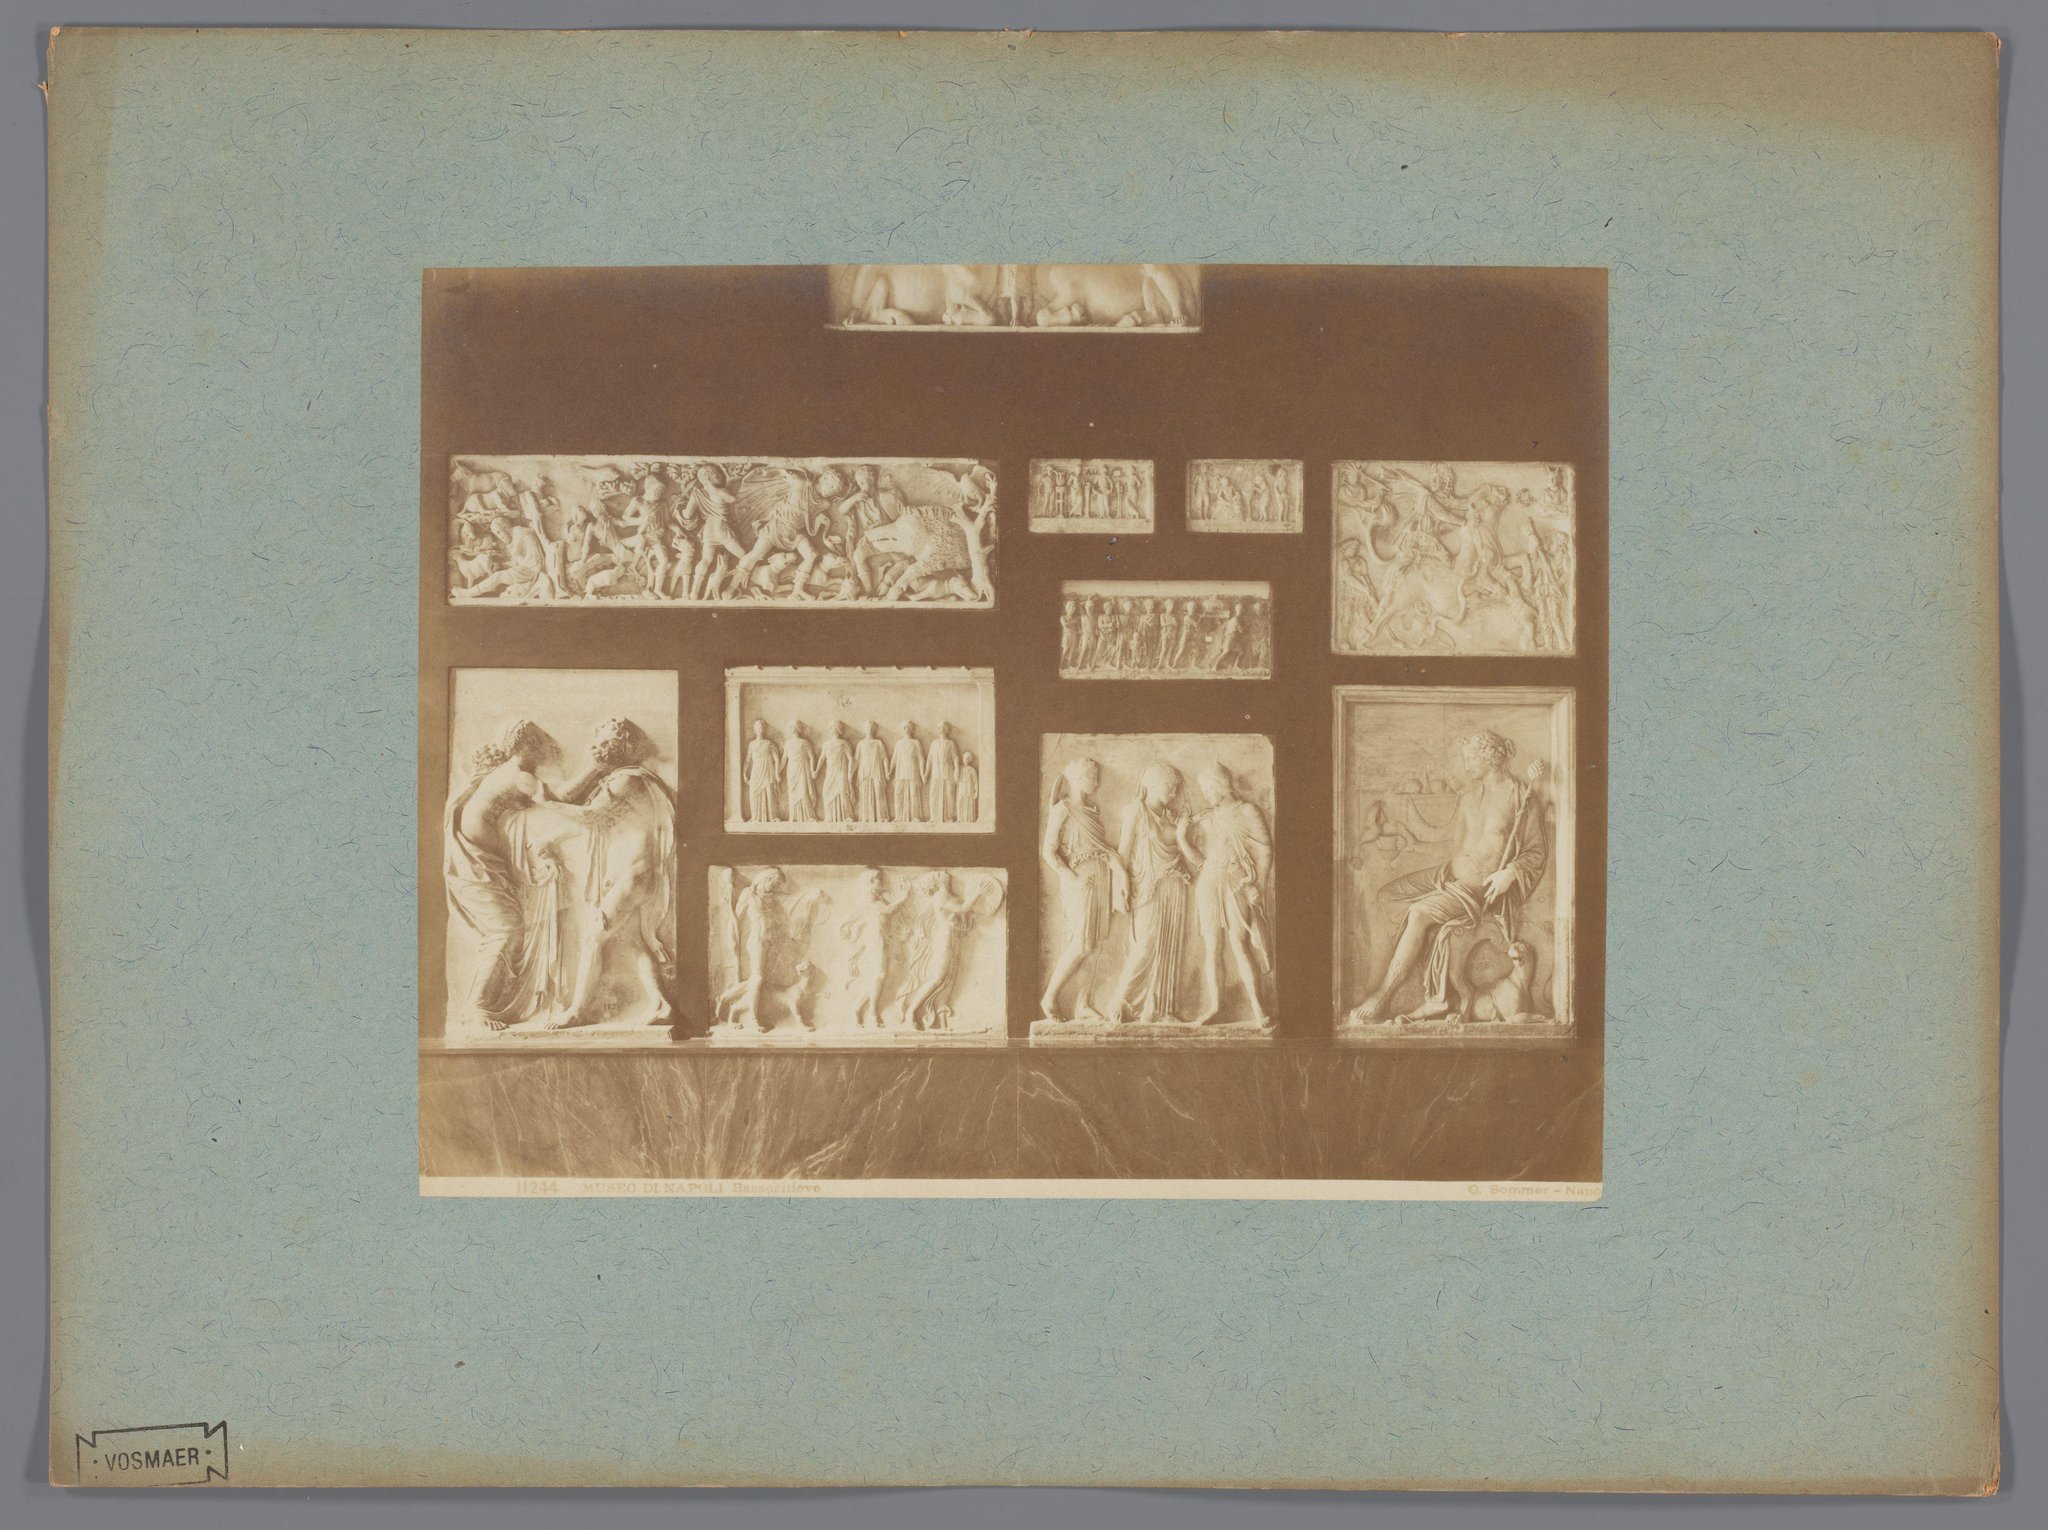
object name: photograph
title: Basreliëfs in het Museo di Napoli te Napels, Italië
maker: giorgio sommer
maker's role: fotograaf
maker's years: 1834-1914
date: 1857-1914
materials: cardboard, paper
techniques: albumen print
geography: naples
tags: piece of sculpture, reproduction of a piece of sculpture, art (+ relief ~ sculpture)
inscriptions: number: ‘11244’, collector's mark: ‘VOSMAER’